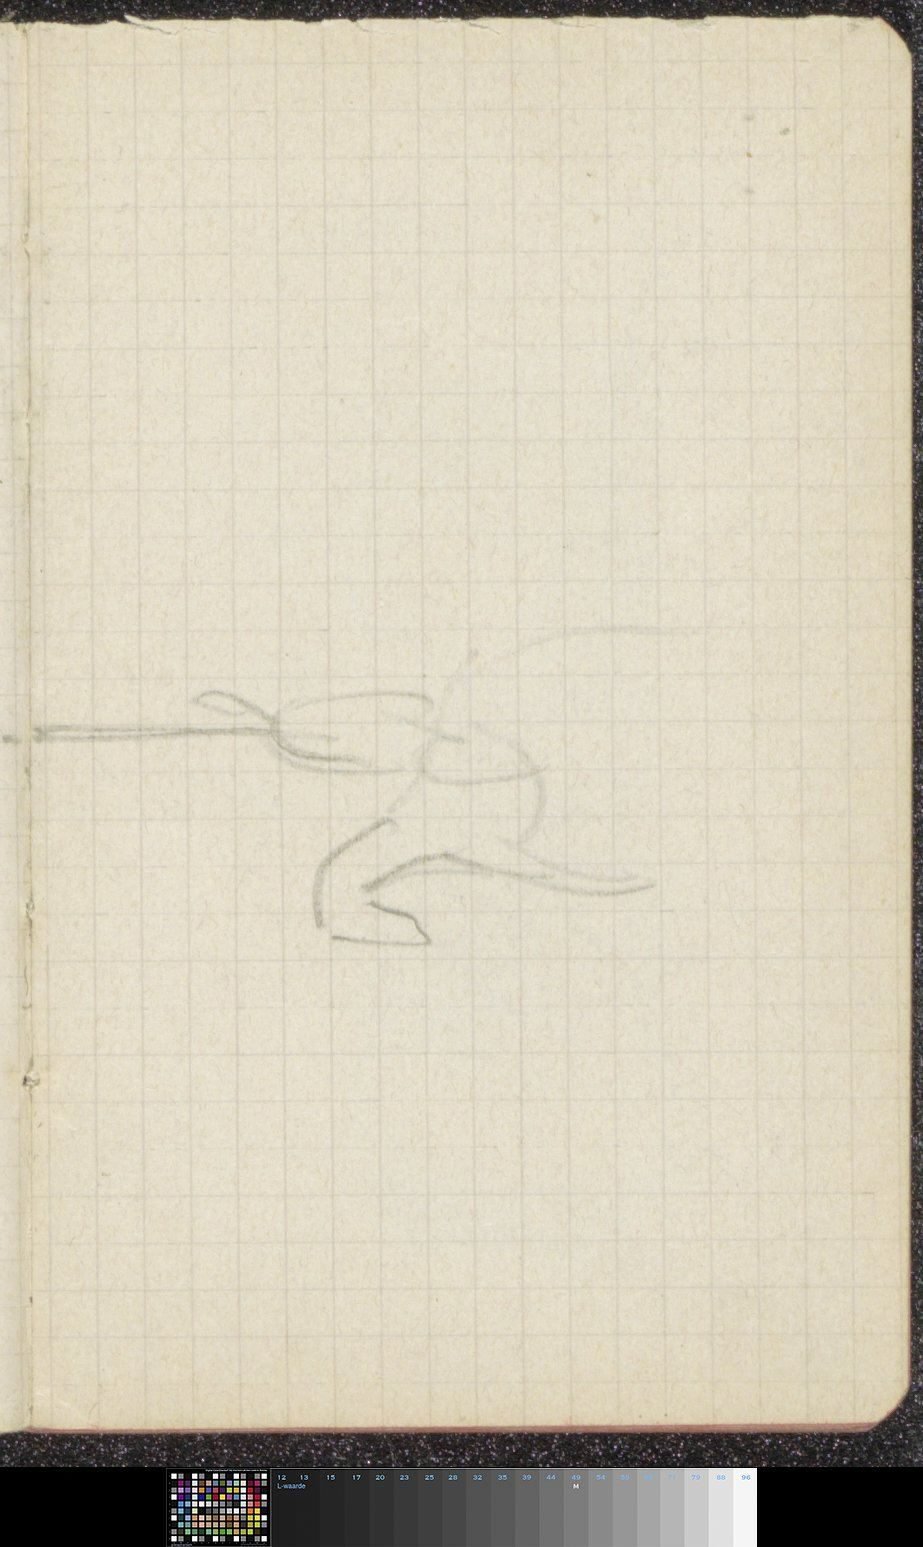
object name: sketchbook leaf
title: Ruiter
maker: marius bauer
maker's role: draughtsman, print maker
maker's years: 1867-1932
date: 1902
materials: pencil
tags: riding a horse, ass, or mule; rider, horseman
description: Pagina 5 uit een schetsboek met 23 bladen.